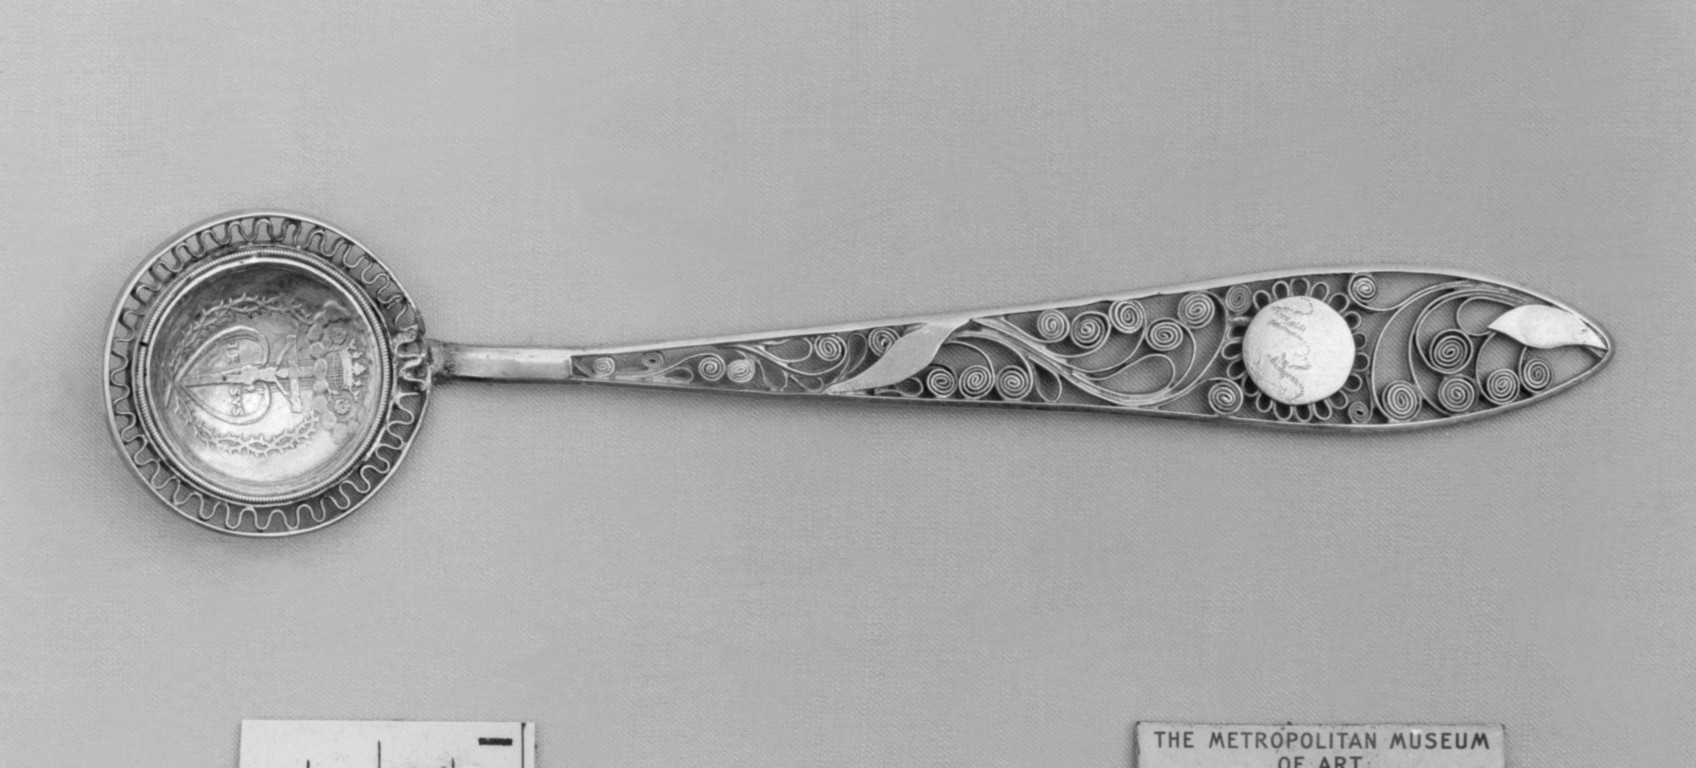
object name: spoon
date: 1801-1900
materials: gilt, silver